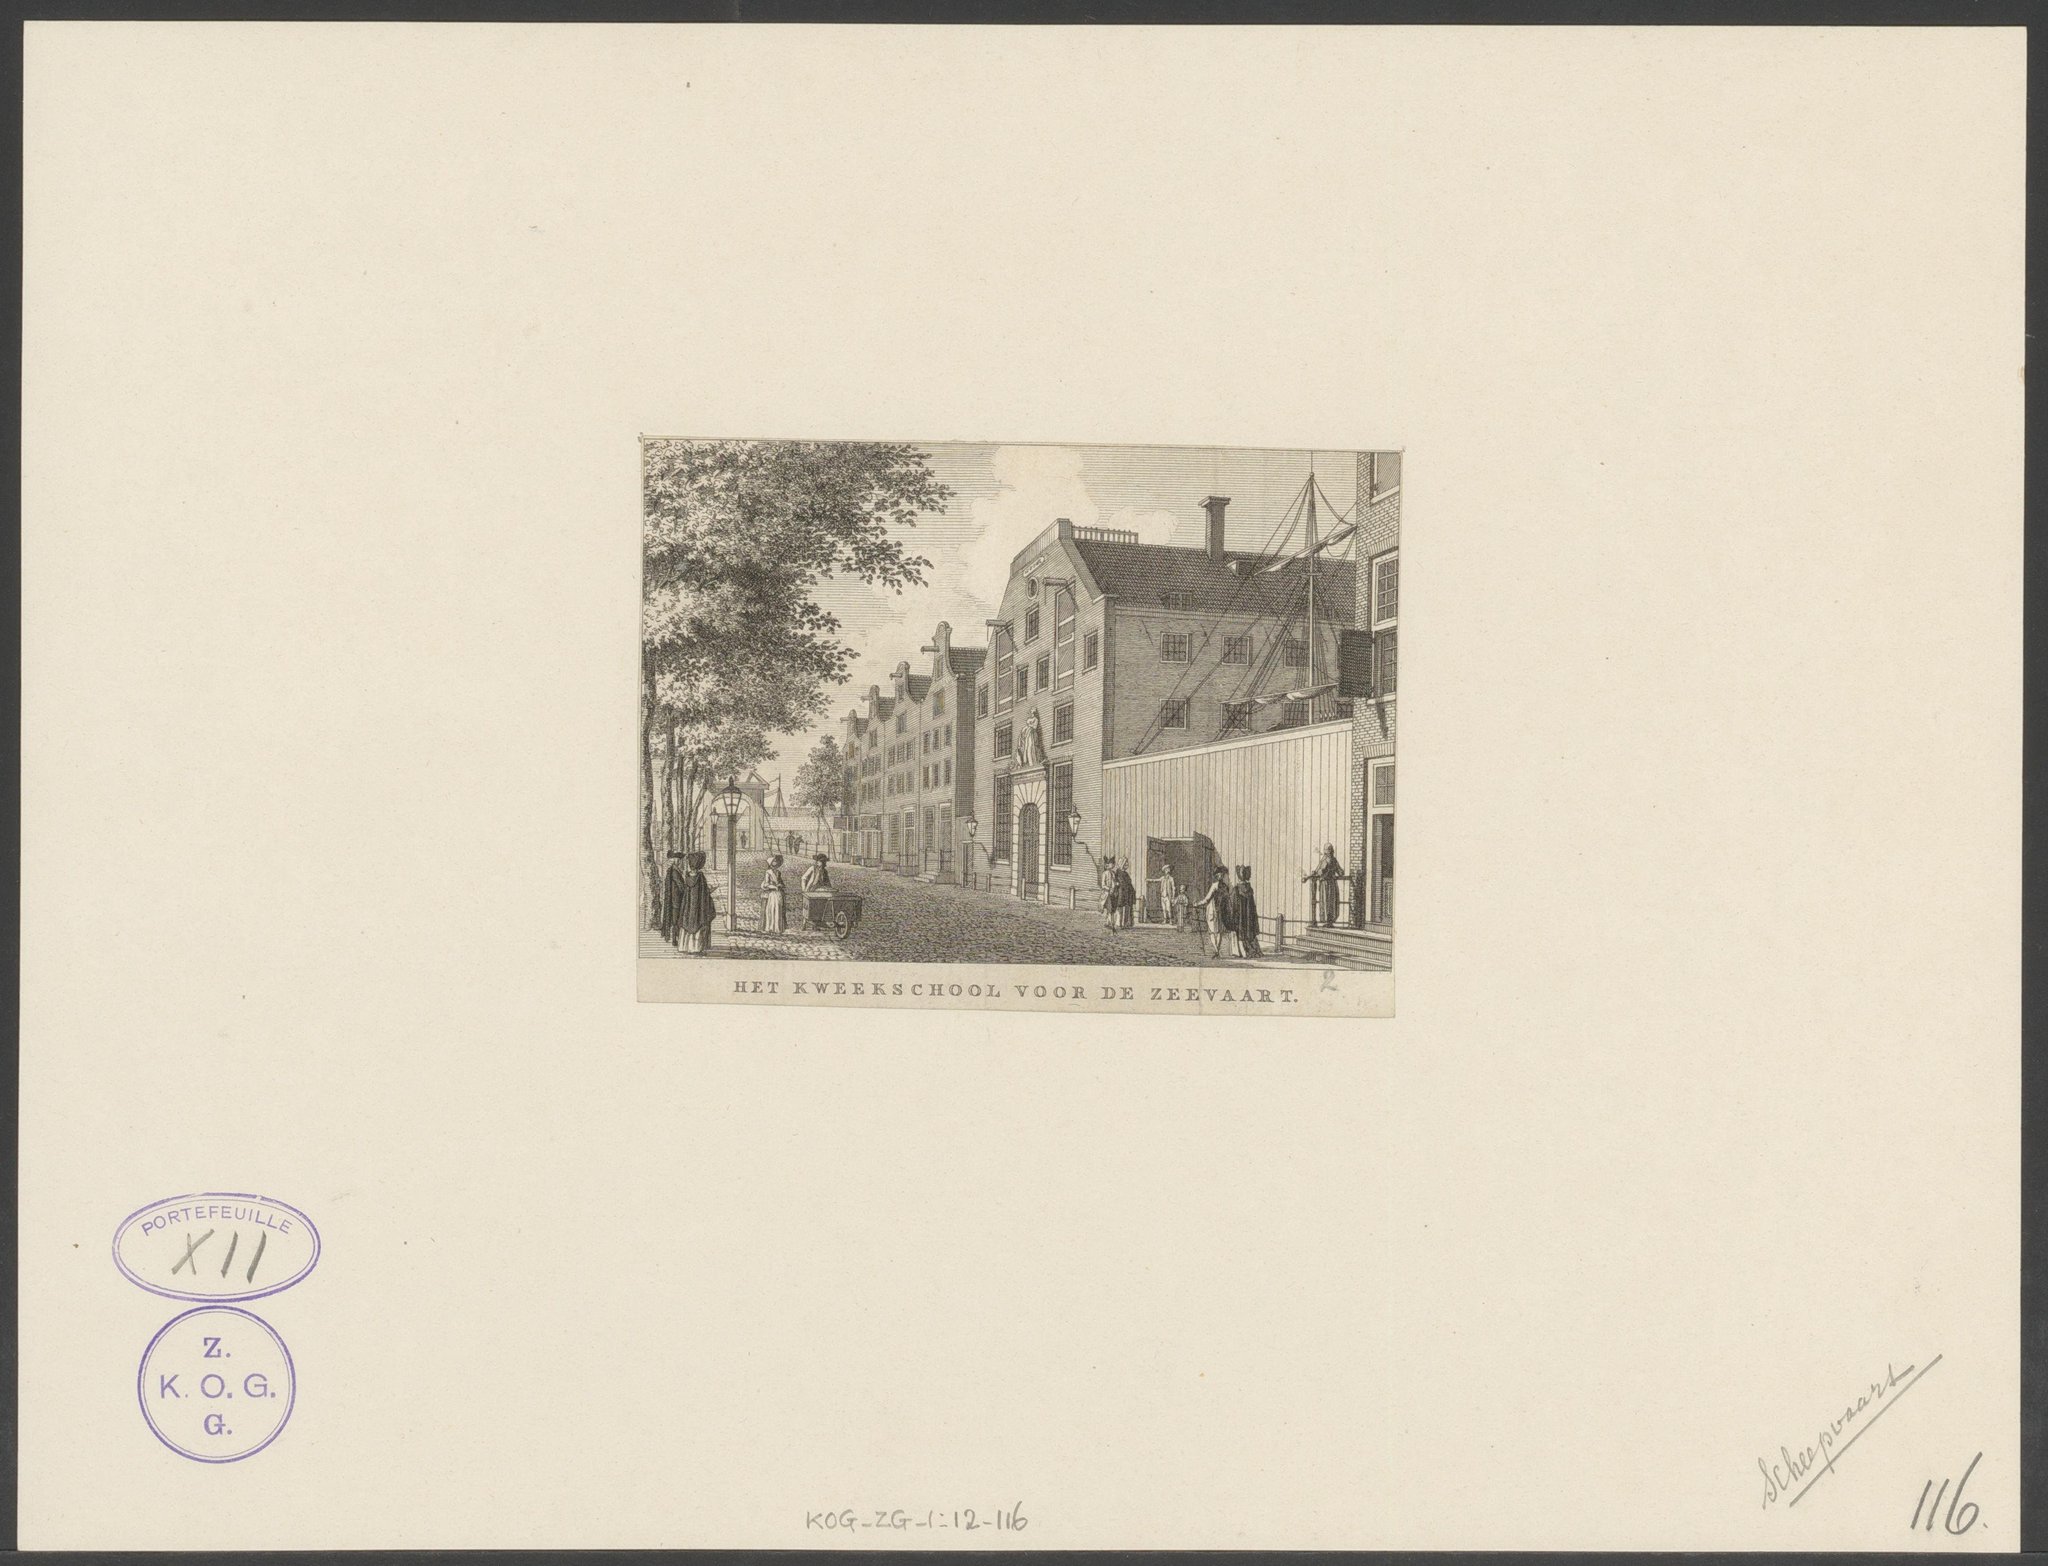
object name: print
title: Het Kweekschool voor de Zeevaart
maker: Anonymous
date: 1790-1824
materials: paper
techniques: etching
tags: secondary education, civic architecture; edifices; dwellings, amsterdam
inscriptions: stamp, collector's mark: Lugt 1641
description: Onderwerpsrubrieken binnen de Atlas Zeden en Gewoonten: Handel, Nijverheid en Verkeer, Scheepsvaart.